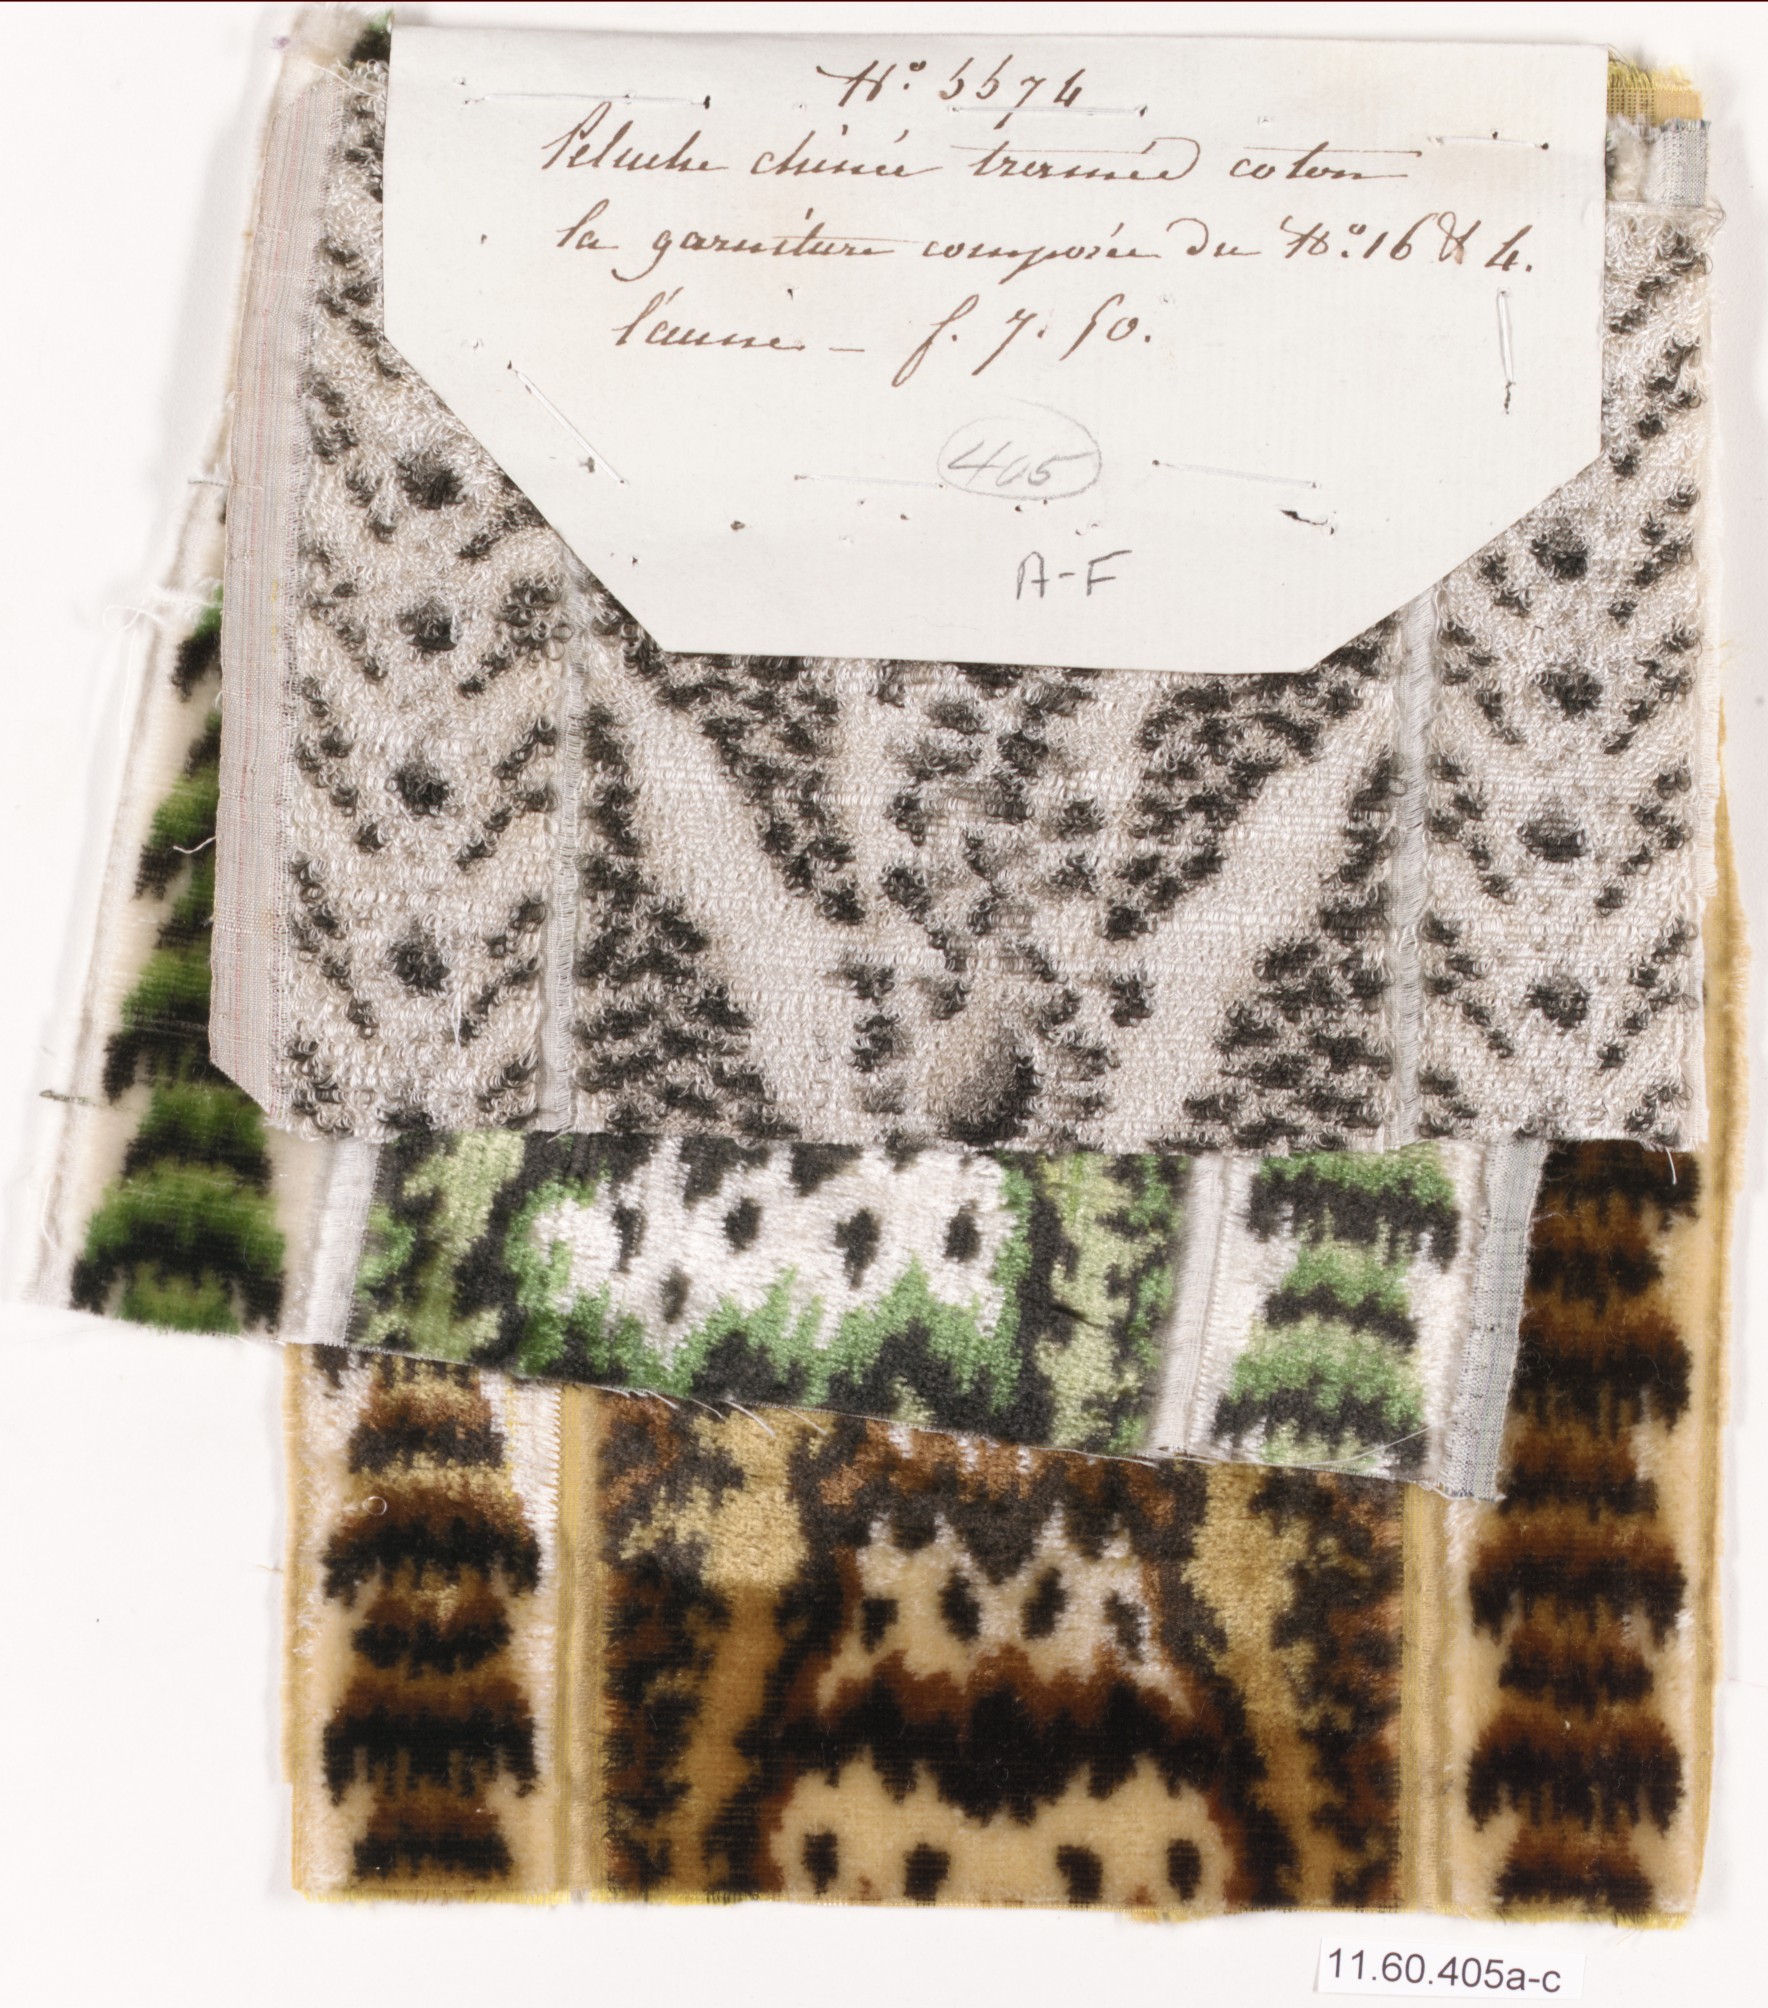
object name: fragment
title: Fragments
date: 1801-1900